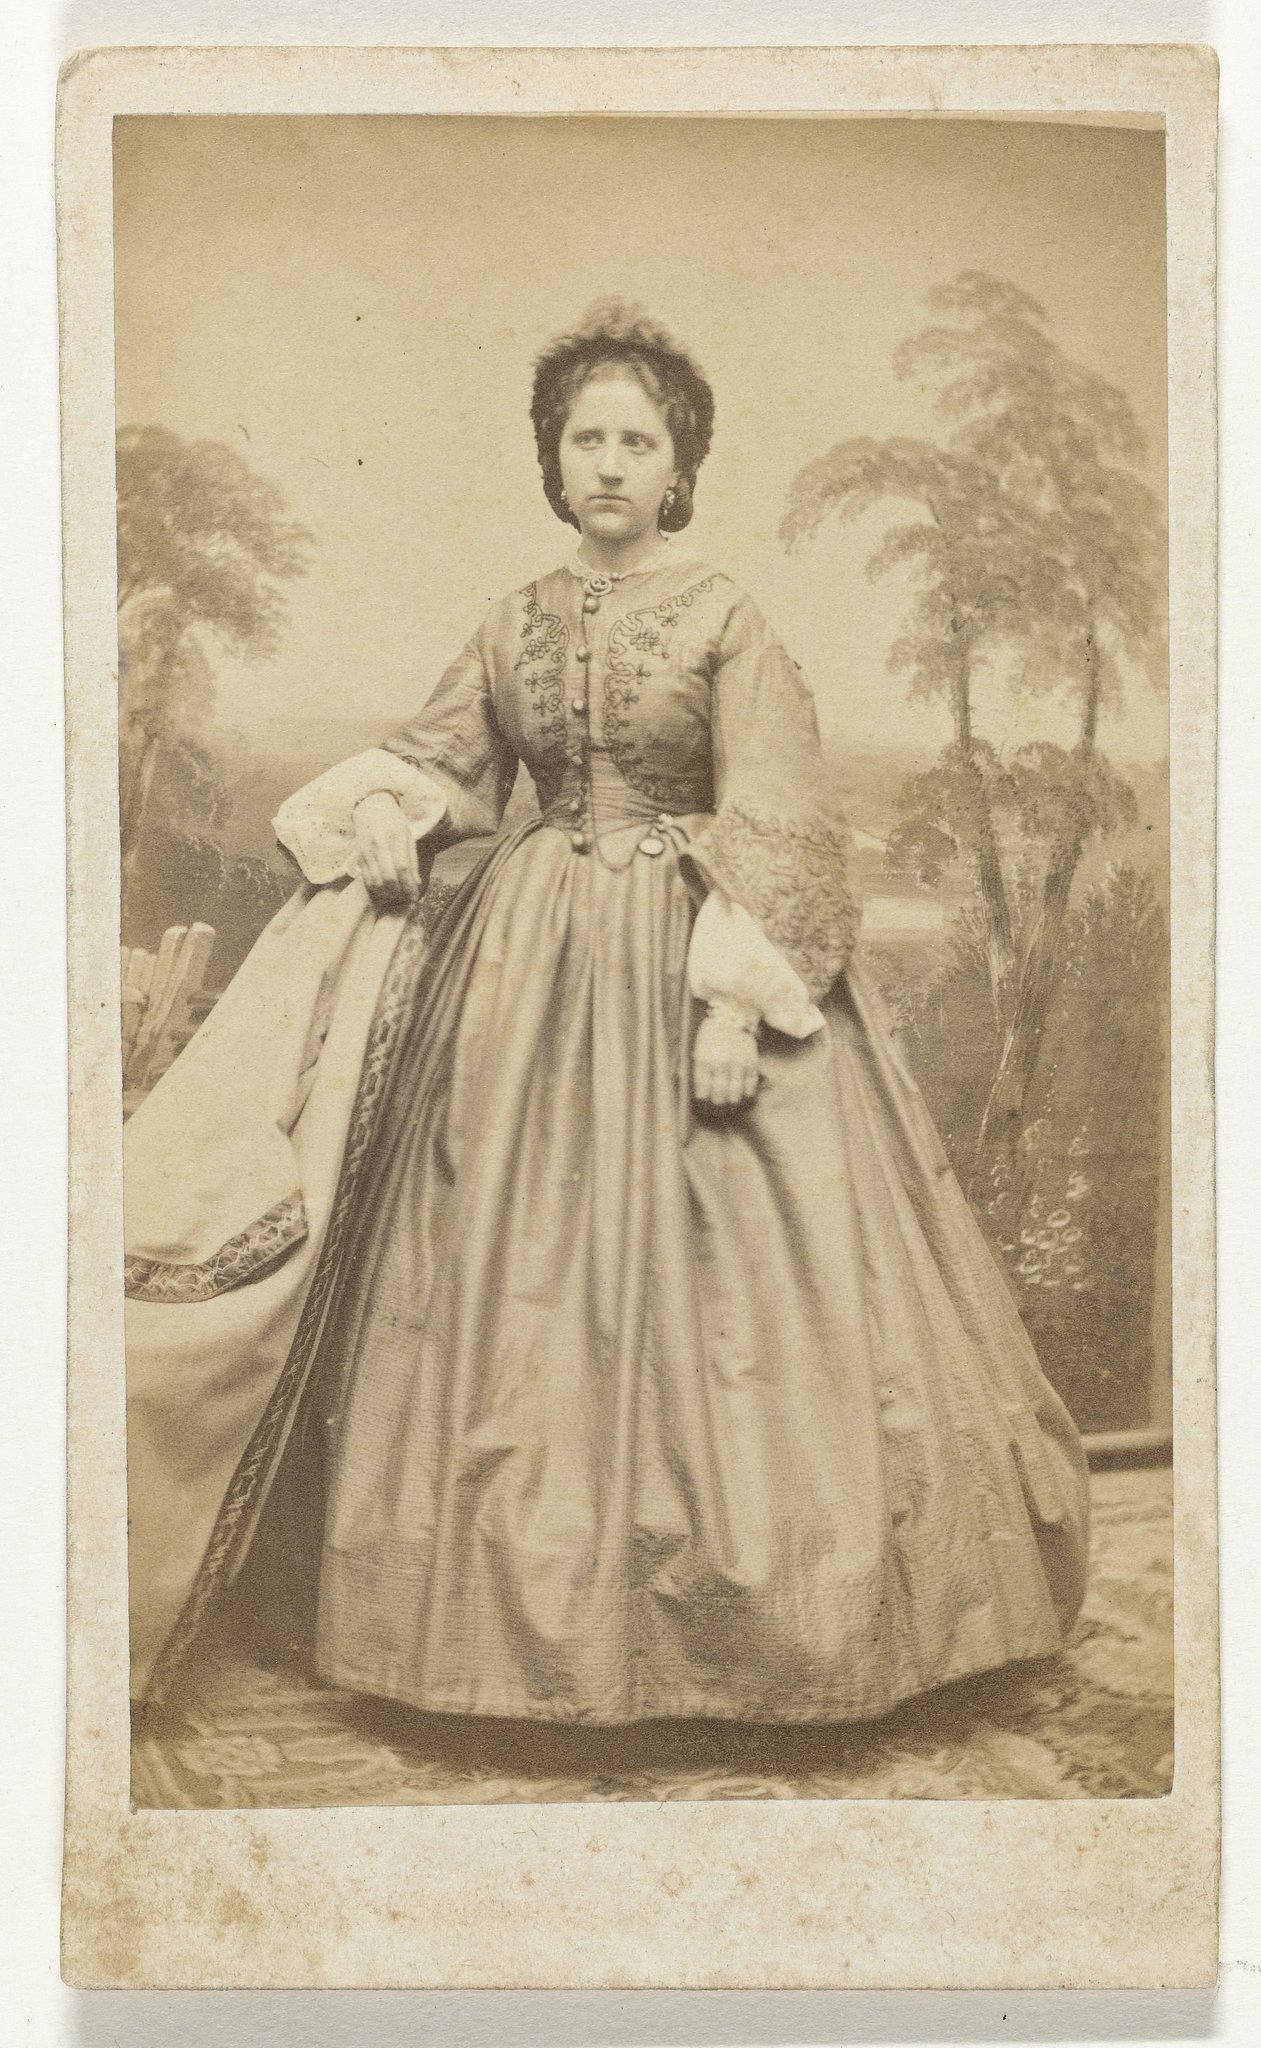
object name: photograph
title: Portret van een vrouw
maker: albert greiner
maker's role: fotograaf, fotostudio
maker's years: 1833-1890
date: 1863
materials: cardboard, paper, photographic support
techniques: albumen print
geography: amsterdam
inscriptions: signature and address: ‘A. Greiner/Photographe/Nieuwendijk/Amsterdam’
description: Staande vrouw, met een arm leunend op een meubel. Een afbeelding van een landschap met hoge bomen als achtergrond.